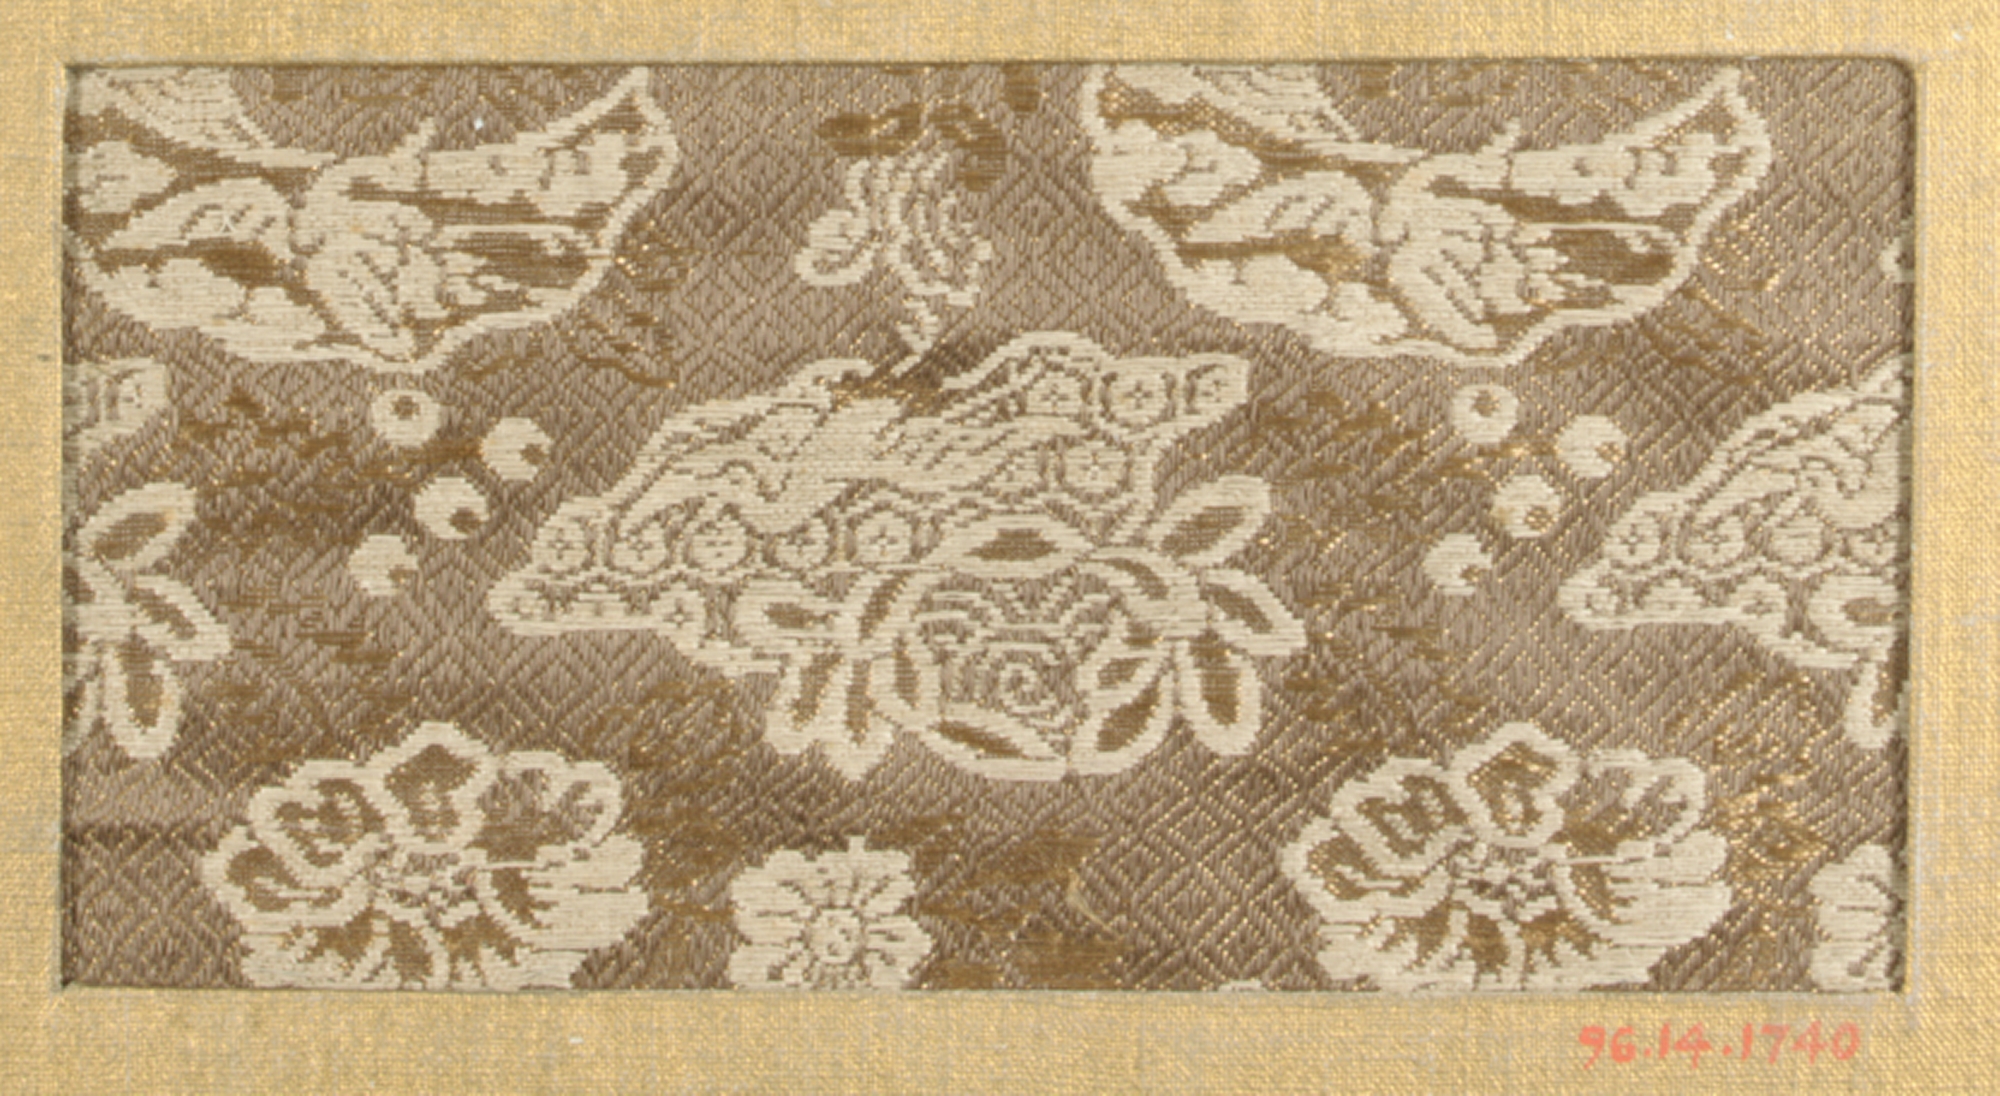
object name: piece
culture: japanese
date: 1701-1900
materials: silk